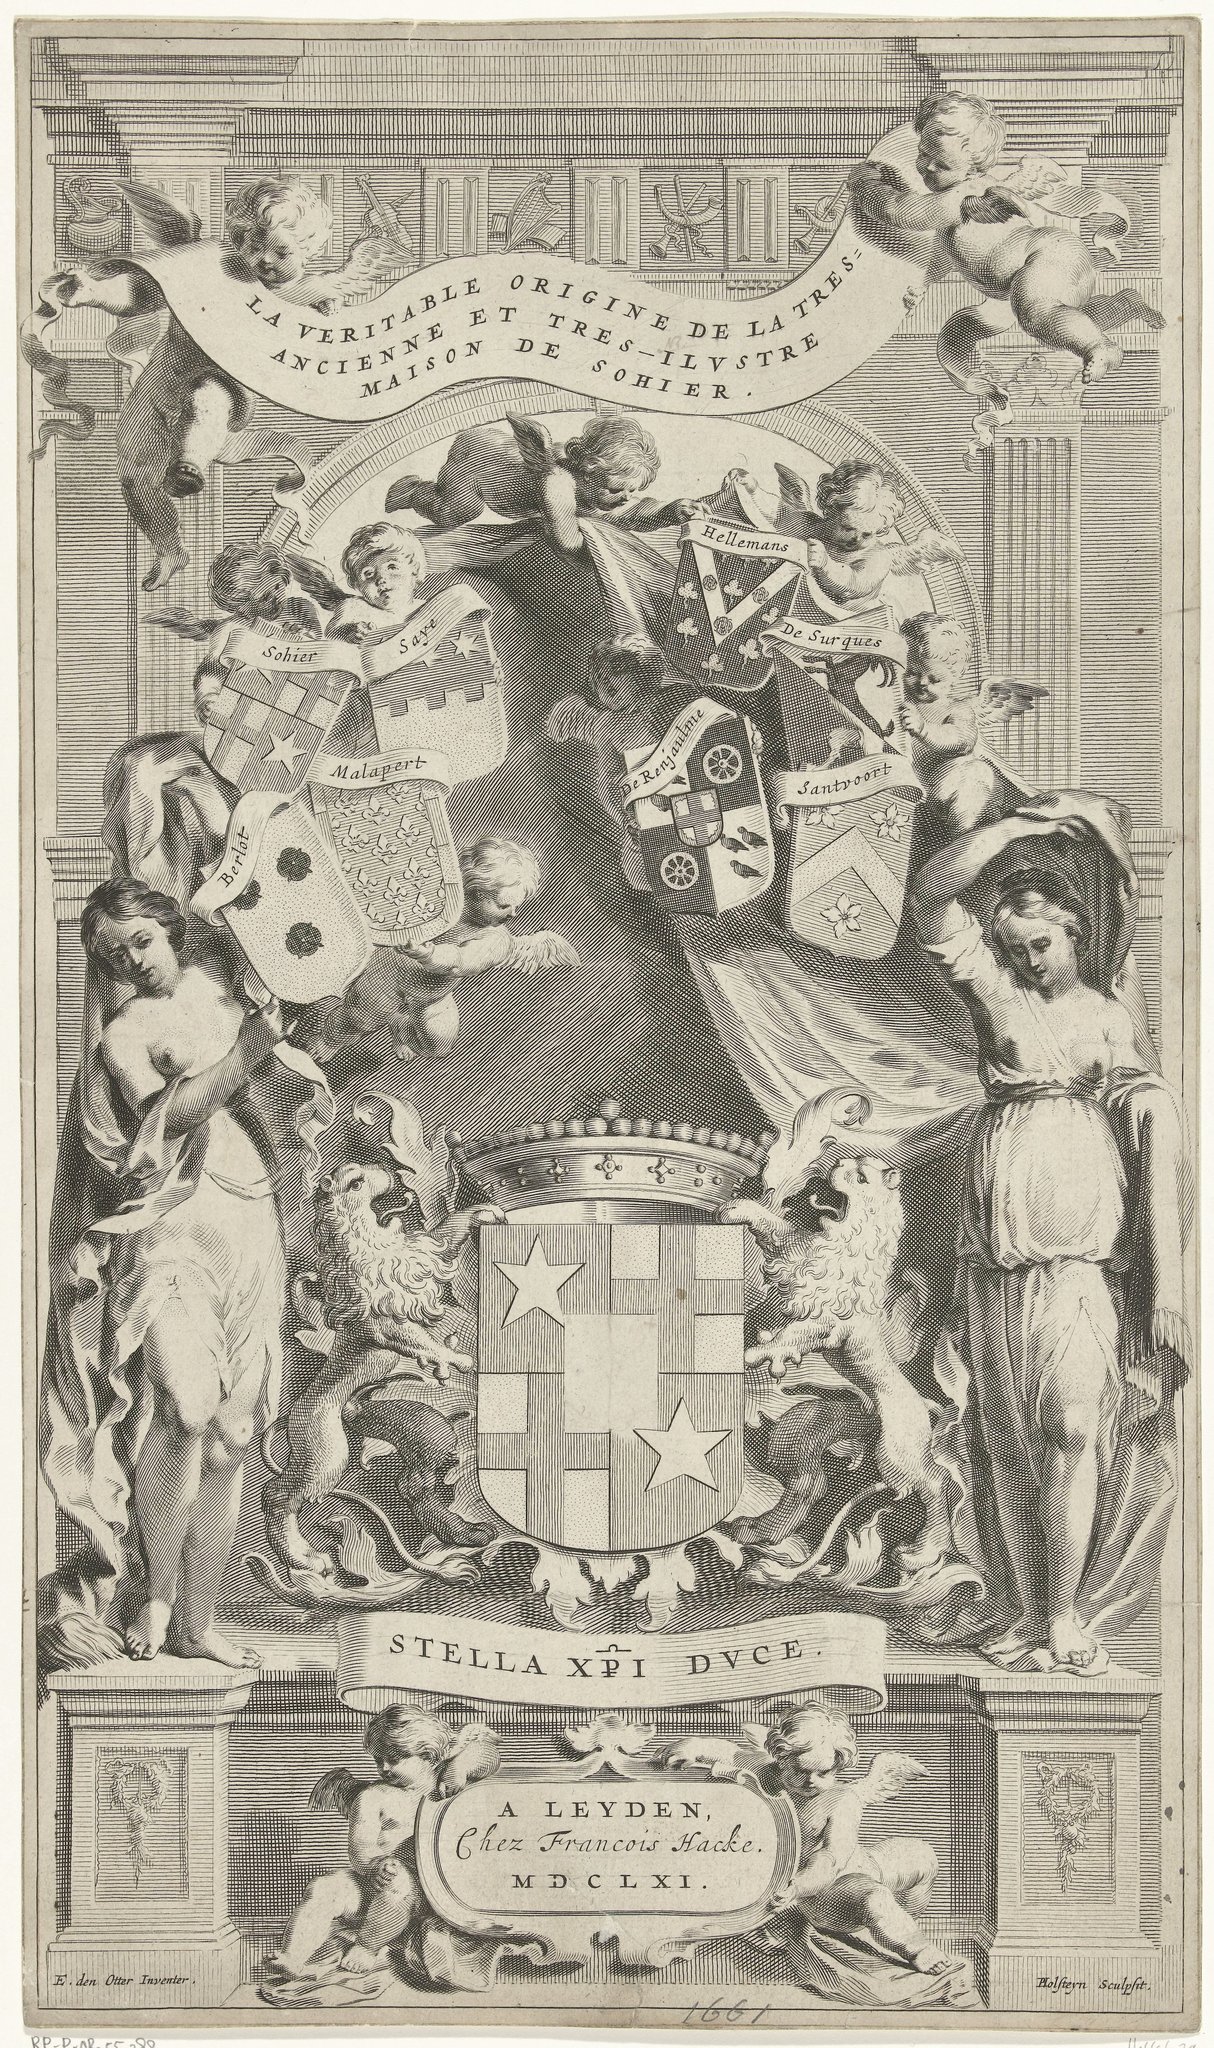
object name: print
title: Titelpagina voor: La veritable origin (...) maison de Sohier, 1661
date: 1661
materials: paper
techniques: engraving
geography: leiden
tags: amsterdam, cupids: 'amores', 'amoretti', 'putti', armorial bearing, heraldry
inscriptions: date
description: Het wapen van Constantin Sohier onder een baldakijn dat wordt opgehouden door putti, die ieder afzonderlijk nog meer wapens vasthouden. Links en rechts een vrouwfiguur op een piëdestal. Onderaan houden twee putti een cartouche vast waarop het impressum. Bovenaan houden twee putti een banderol vast met de titel in drie regels in het Frans